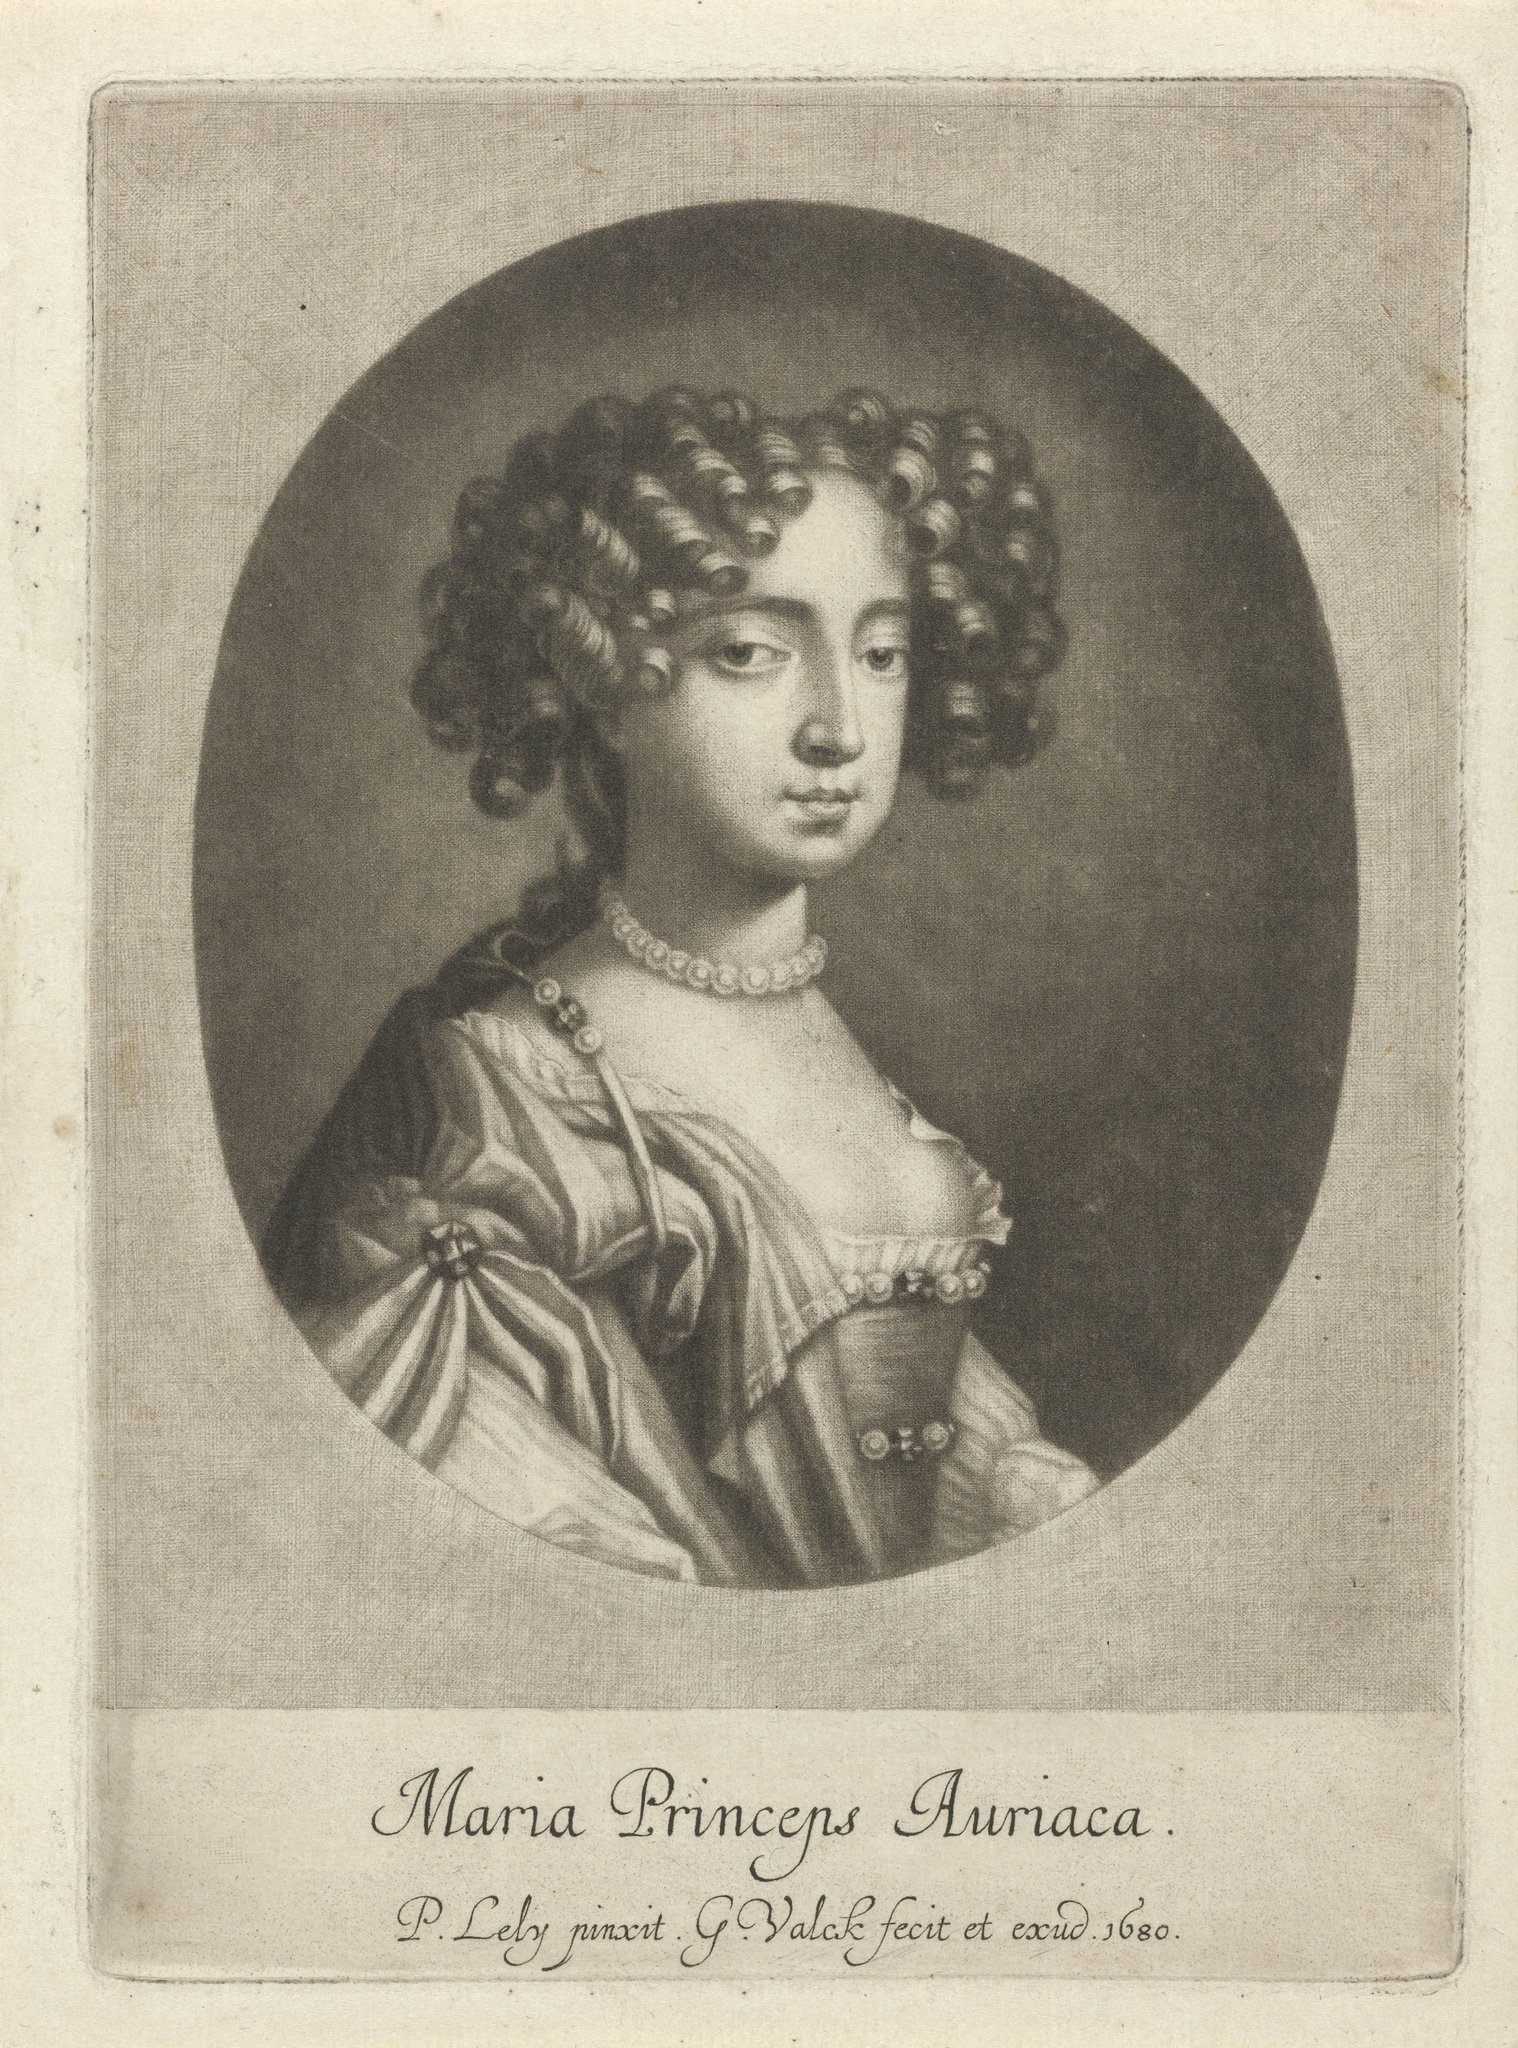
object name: print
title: Portret van Maria II Stuart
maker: peter lely (sir)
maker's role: draughtsman, painter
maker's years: 1618-1680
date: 1680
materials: paper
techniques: mezzotint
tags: london, maria ii stuart (koningin van engeland, schotland en ierland)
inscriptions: collector's mark: Lugt 2228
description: Portret van Maria II in een ovaal. In de ondermarge haar naam en titel.